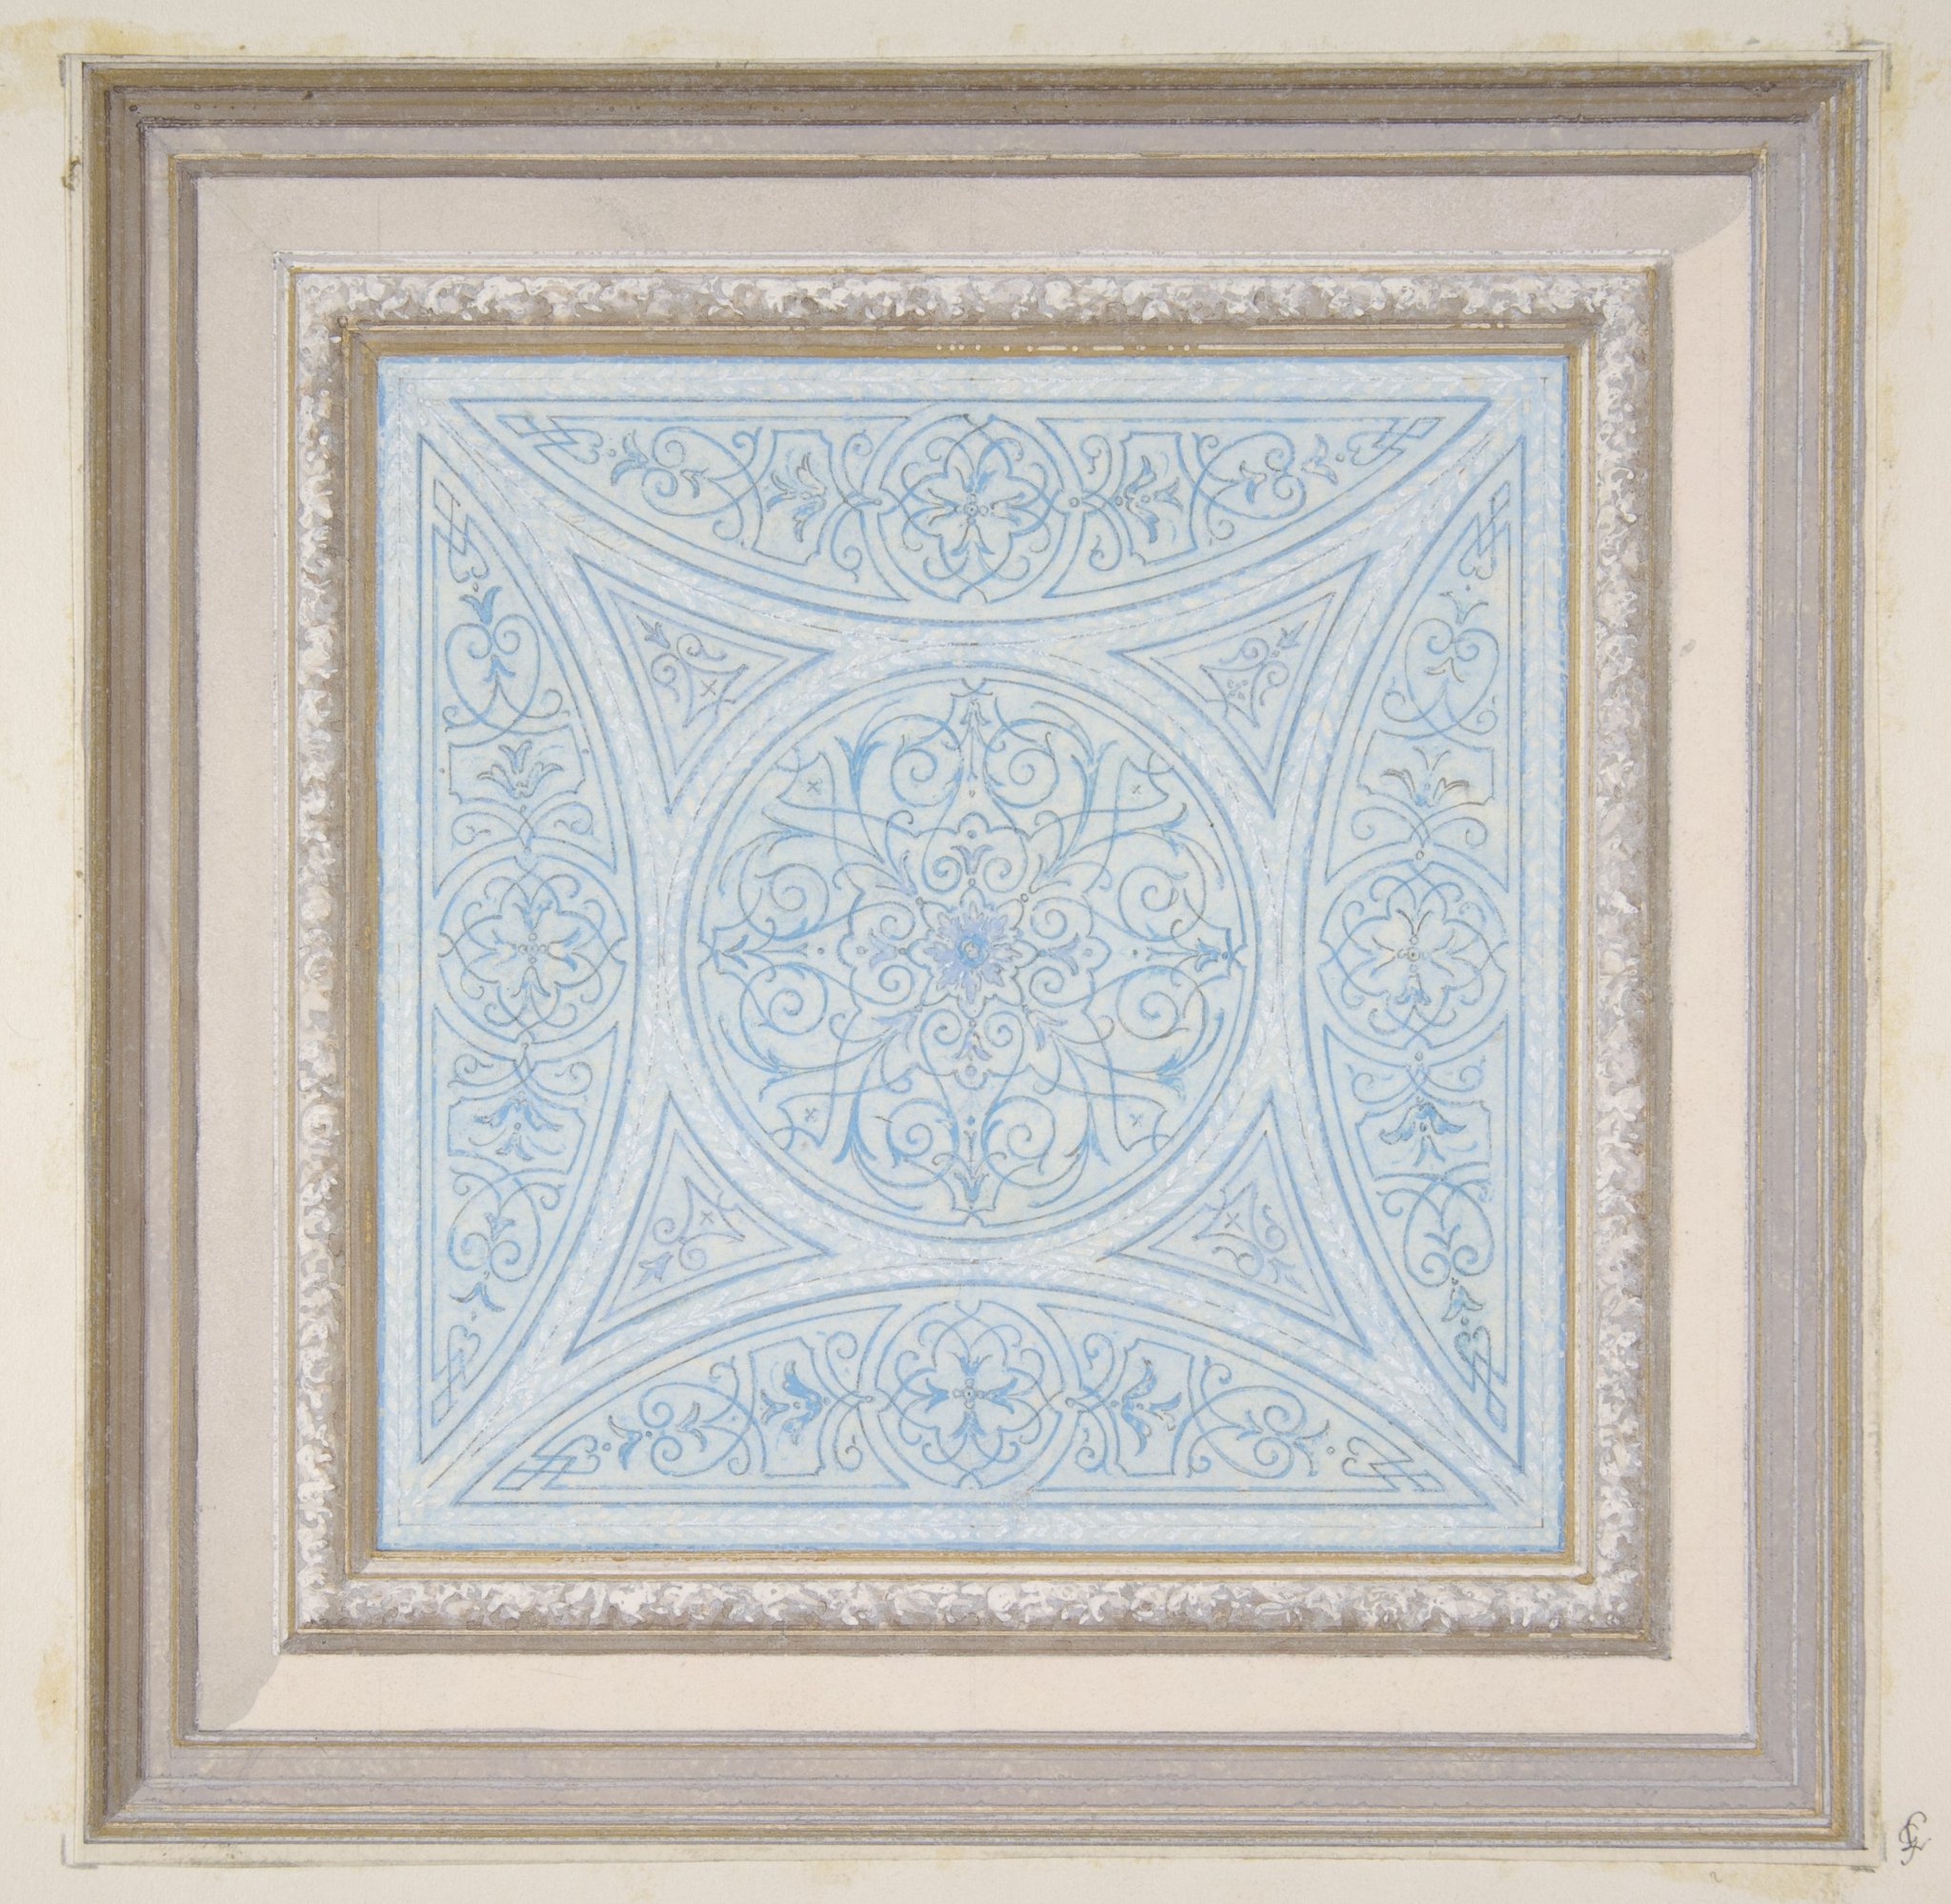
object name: drawing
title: Design for a ceiling paianted in filagree patterns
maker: jules-edmond-charles lachaise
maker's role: artist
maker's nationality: french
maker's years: 1897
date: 1830-1897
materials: gold paint, gouache, watercolor, paper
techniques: inlay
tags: ceilings